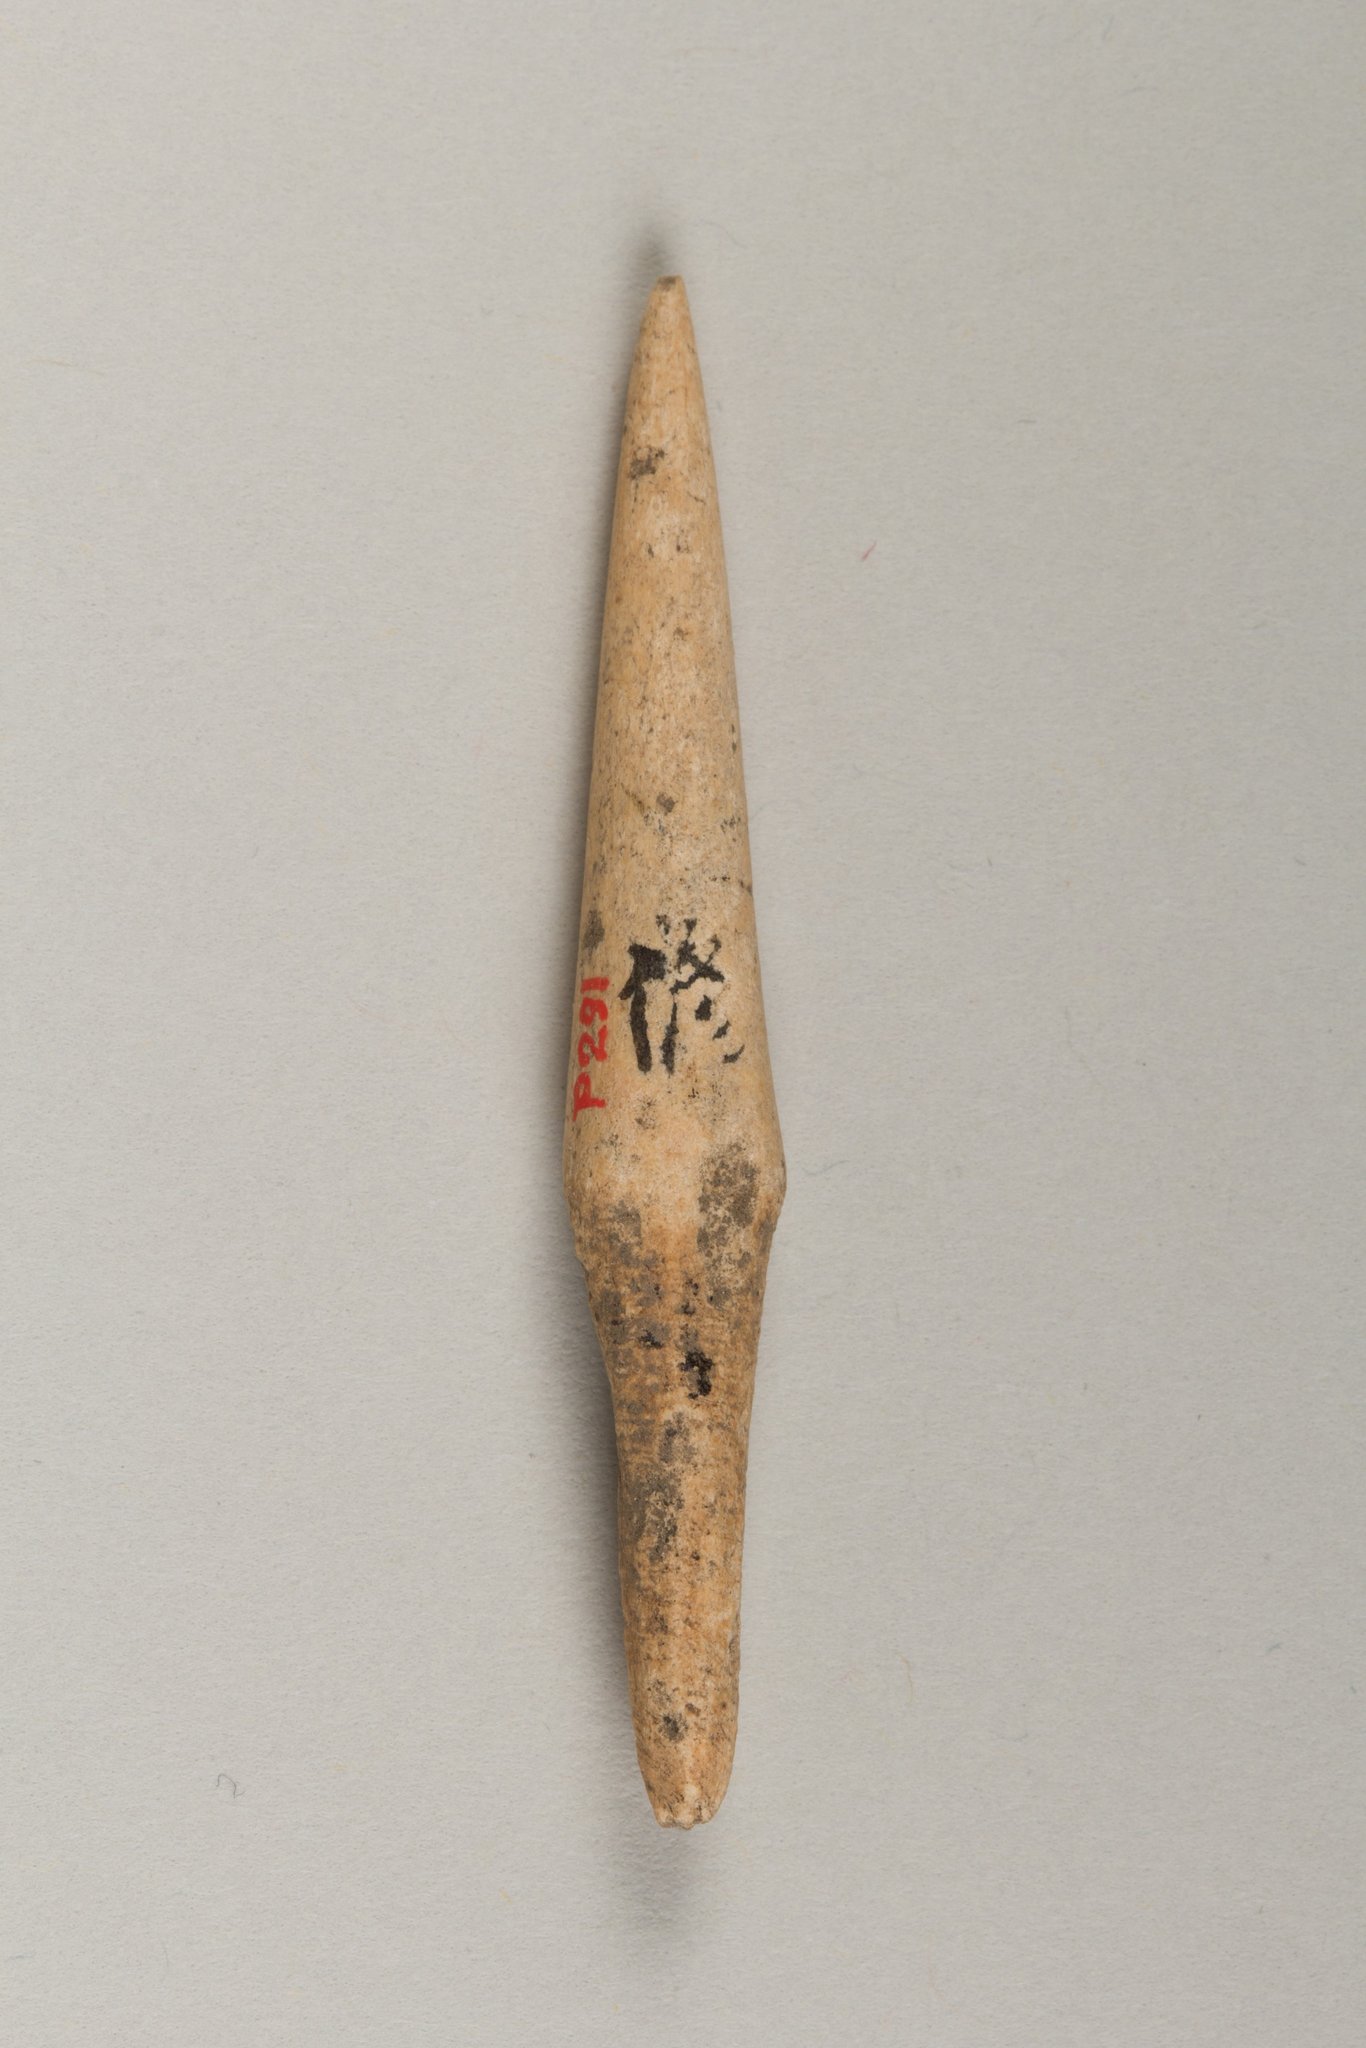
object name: harpoon head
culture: japanese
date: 1000-300 BCE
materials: bone